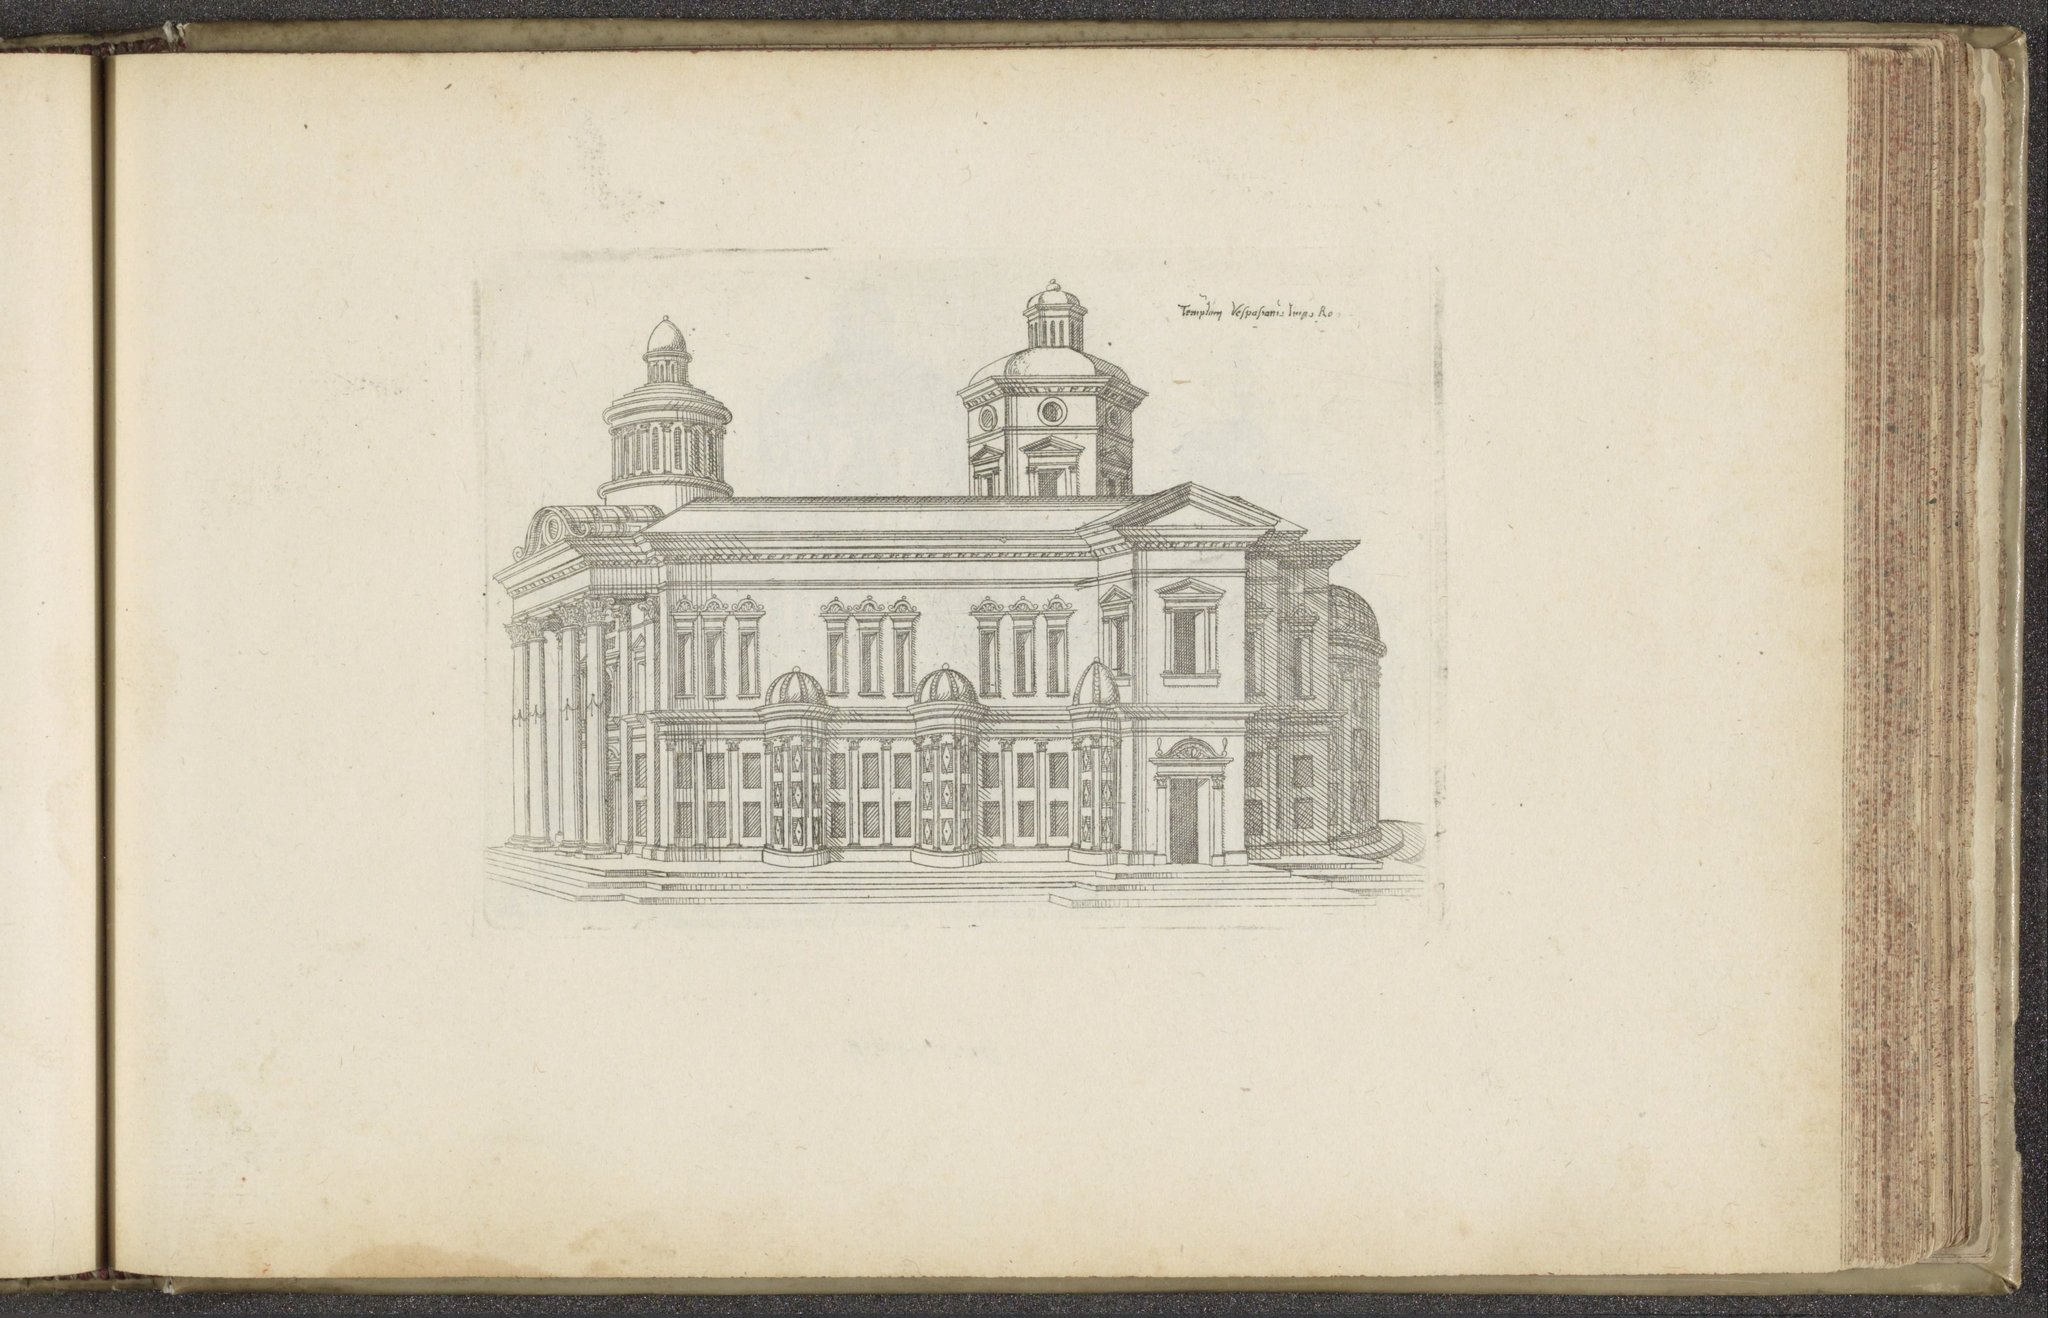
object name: print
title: Heiligdom met links een zuilenportaal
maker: jacques androuet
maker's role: draughtsman, print maker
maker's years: 1515-1584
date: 1550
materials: paper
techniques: etching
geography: orléans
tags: temple, shrine ~ roman religion, exterior ~ representation of a building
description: Heiligdom met links een zuilenportaal. Deze prent maakt deel uit van een album.